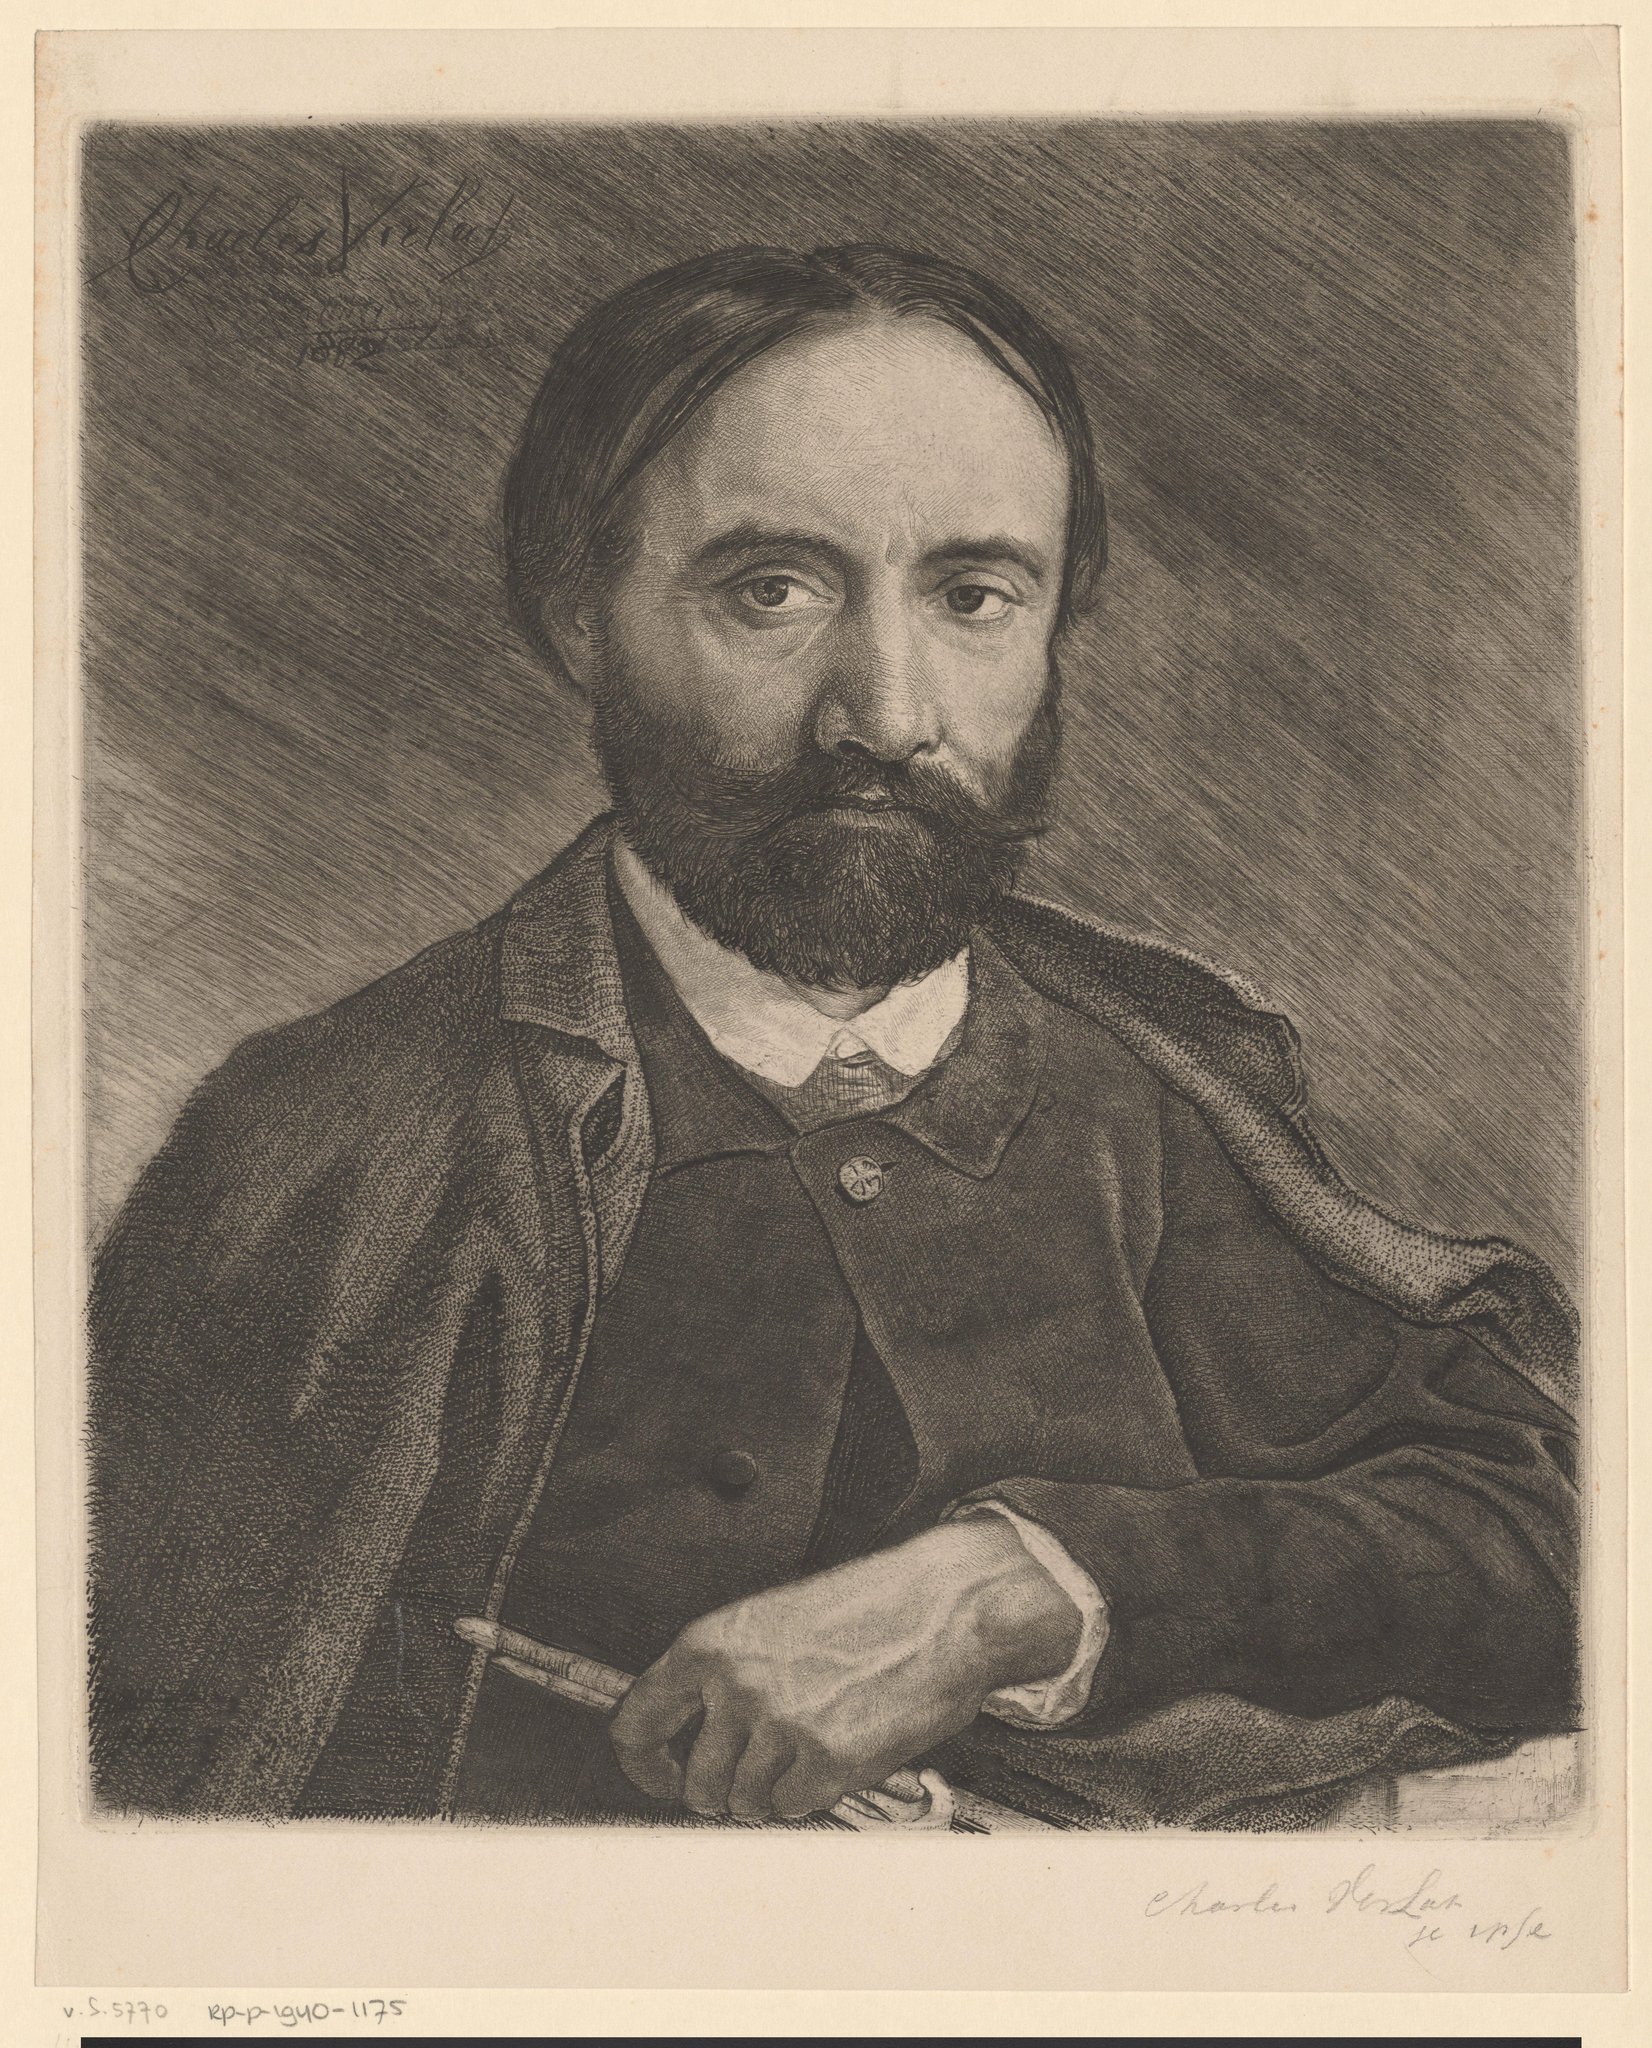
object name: print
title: Zelfportret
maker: charles verlat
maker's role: painter, print maker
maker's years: 1824-1890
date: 1882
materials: paper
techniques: etching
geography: antwerp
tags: antwerp, painter, print maker, charles verlat, historical persons, portrait, self-portrait of painter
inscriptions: collector's mark: Lugt 2760, collector's mark: Lugt 2228